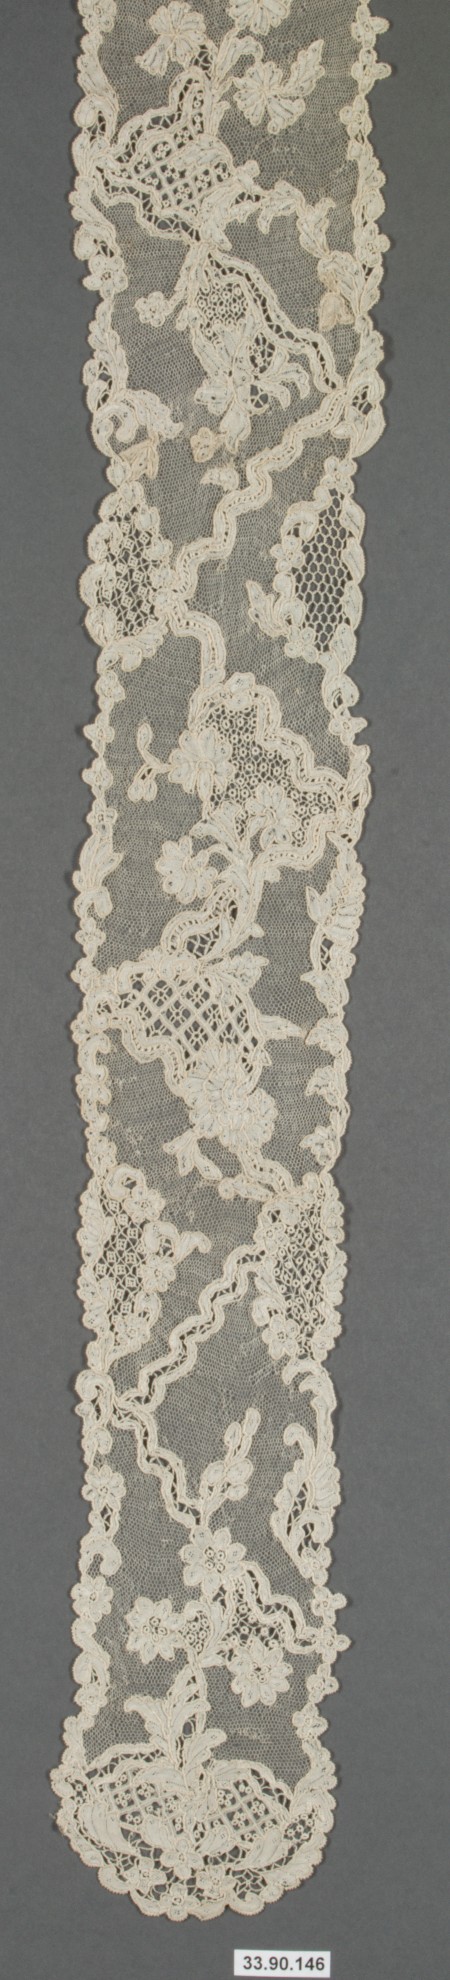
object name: lappet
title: Pair of lappets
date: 1701-1800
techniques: lace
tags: flowers